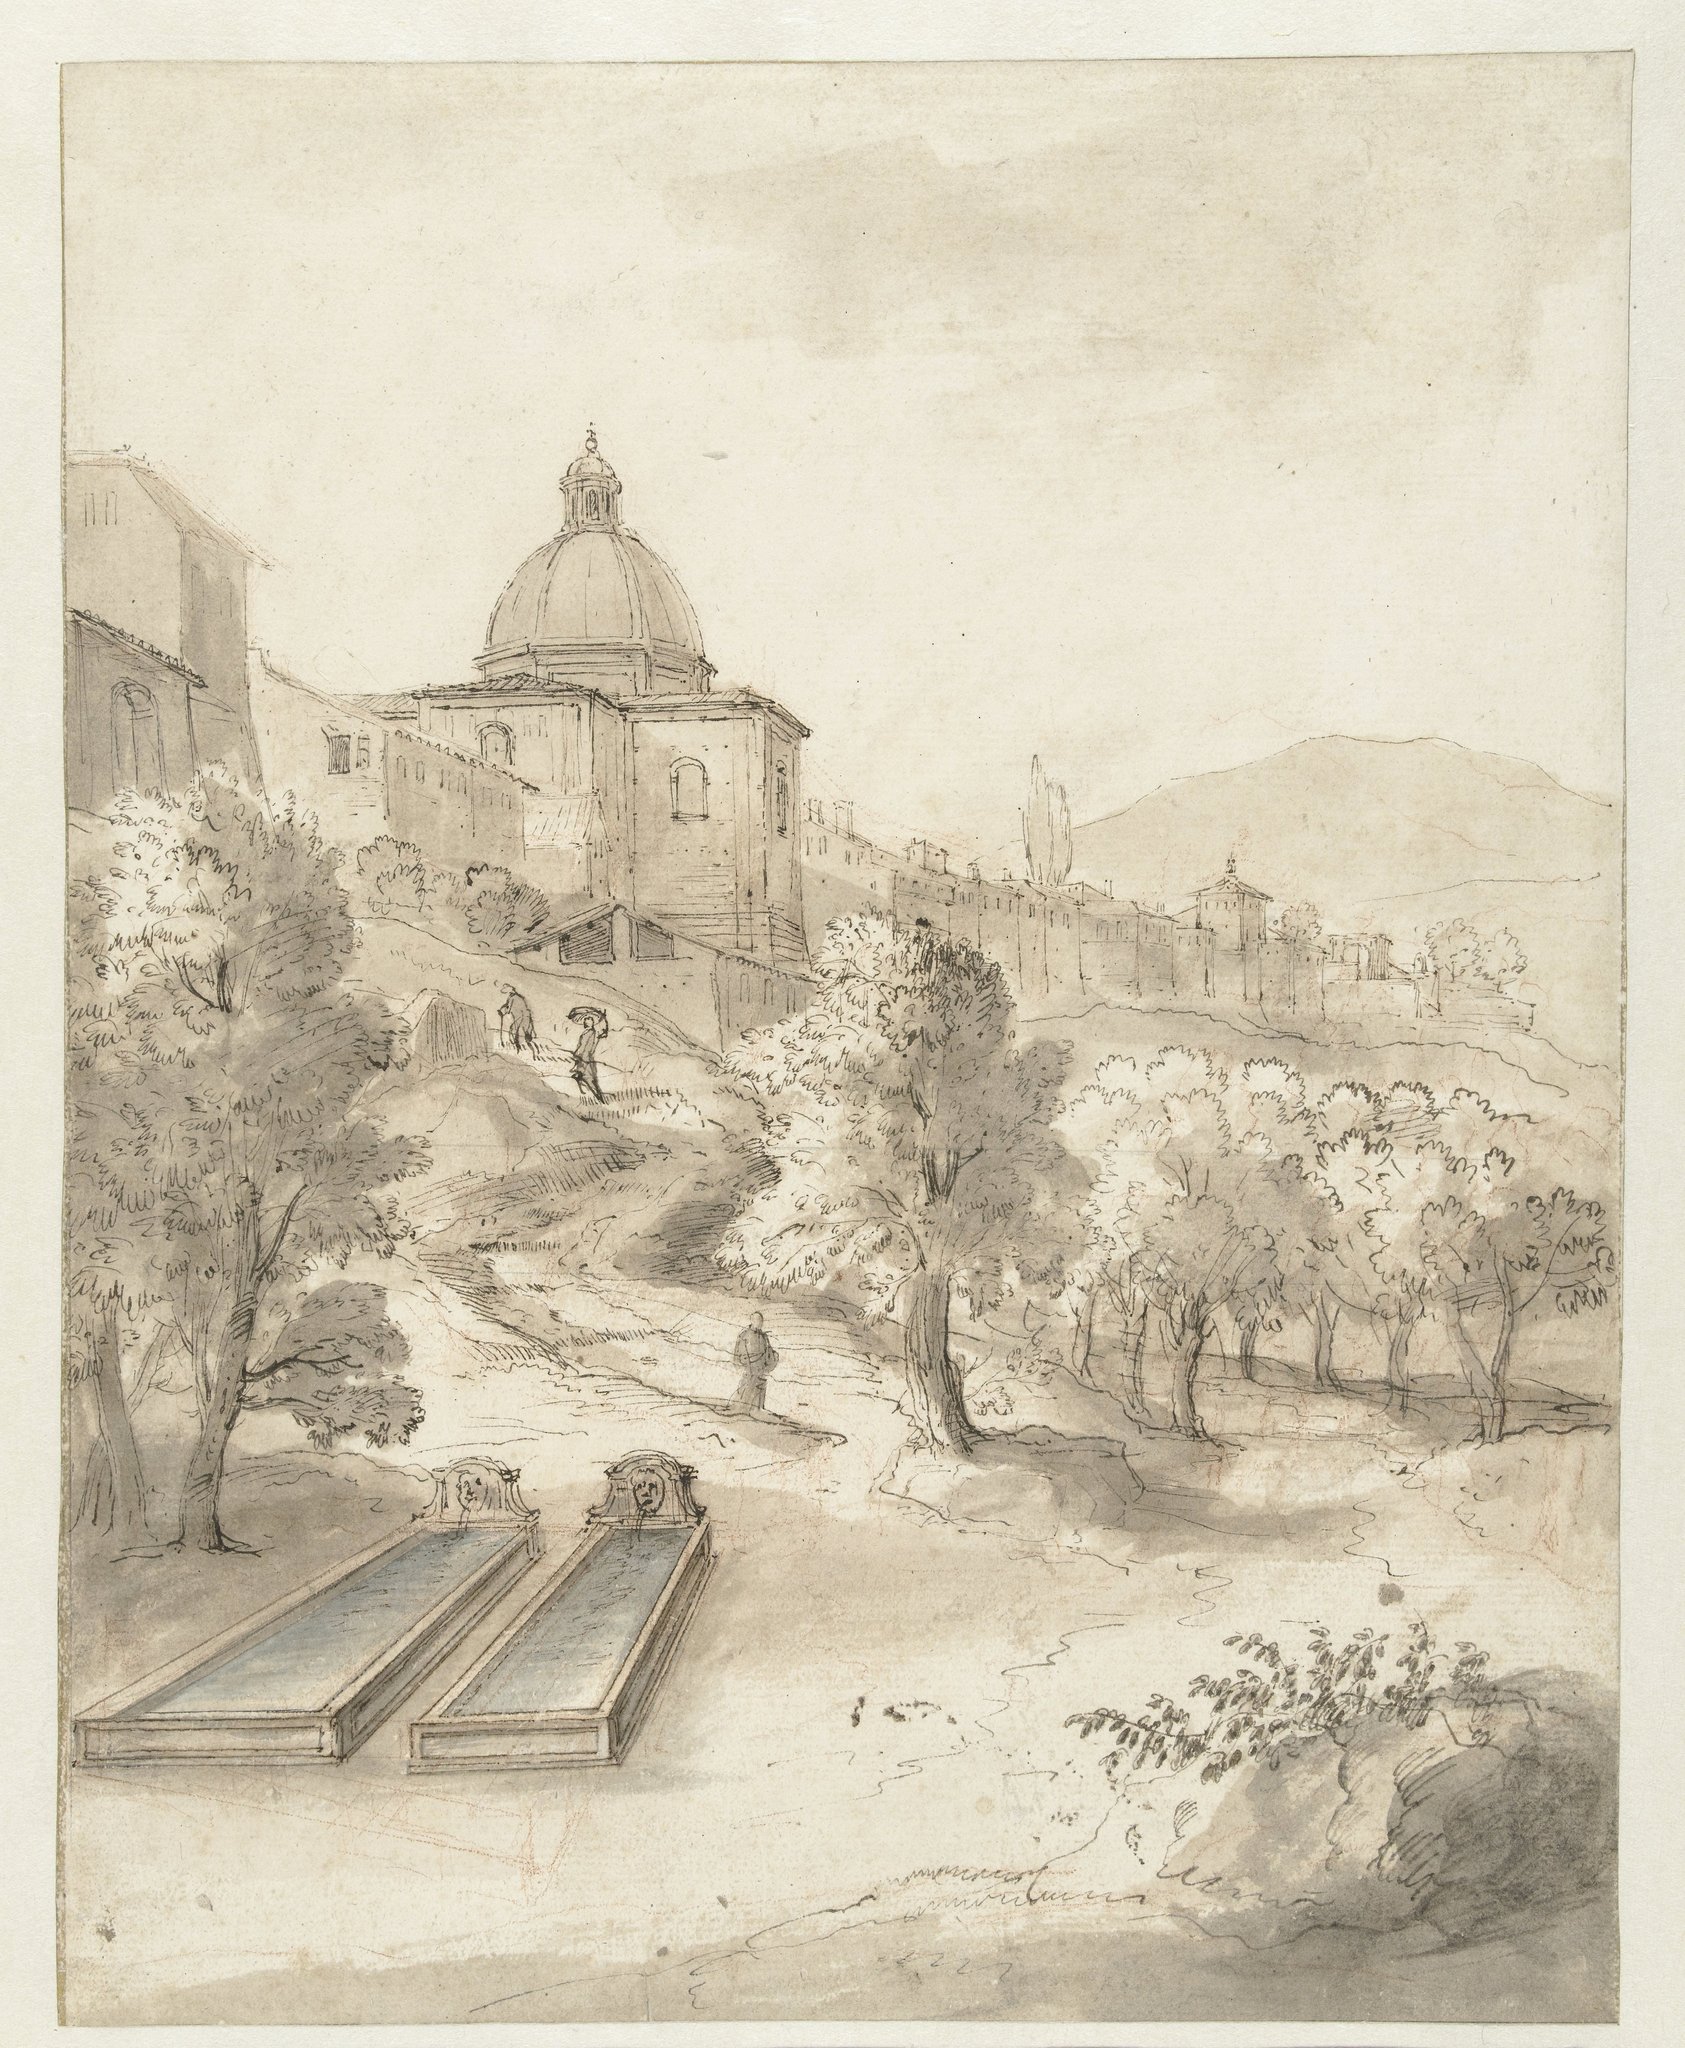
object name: drawing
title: Italian Landscape with a City on a Hill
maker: caspar van wittel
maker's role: draughtsman, painter, print maker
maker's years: 1652-1736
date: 1674-1736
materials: chalk, ink, paper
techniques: brush, pen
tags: low hill country, prospect of city, town panorama, silhouette of city, italy